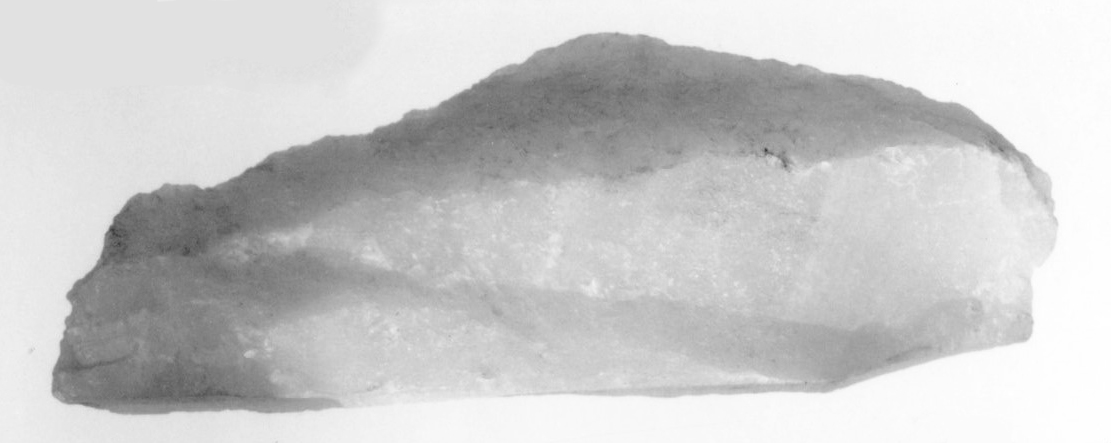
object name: canopic box, siptah, top surface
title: Fragment of the Interior surface of Siptah's Canopic Chest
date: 1194-1188 BCE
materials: stone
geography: egypt